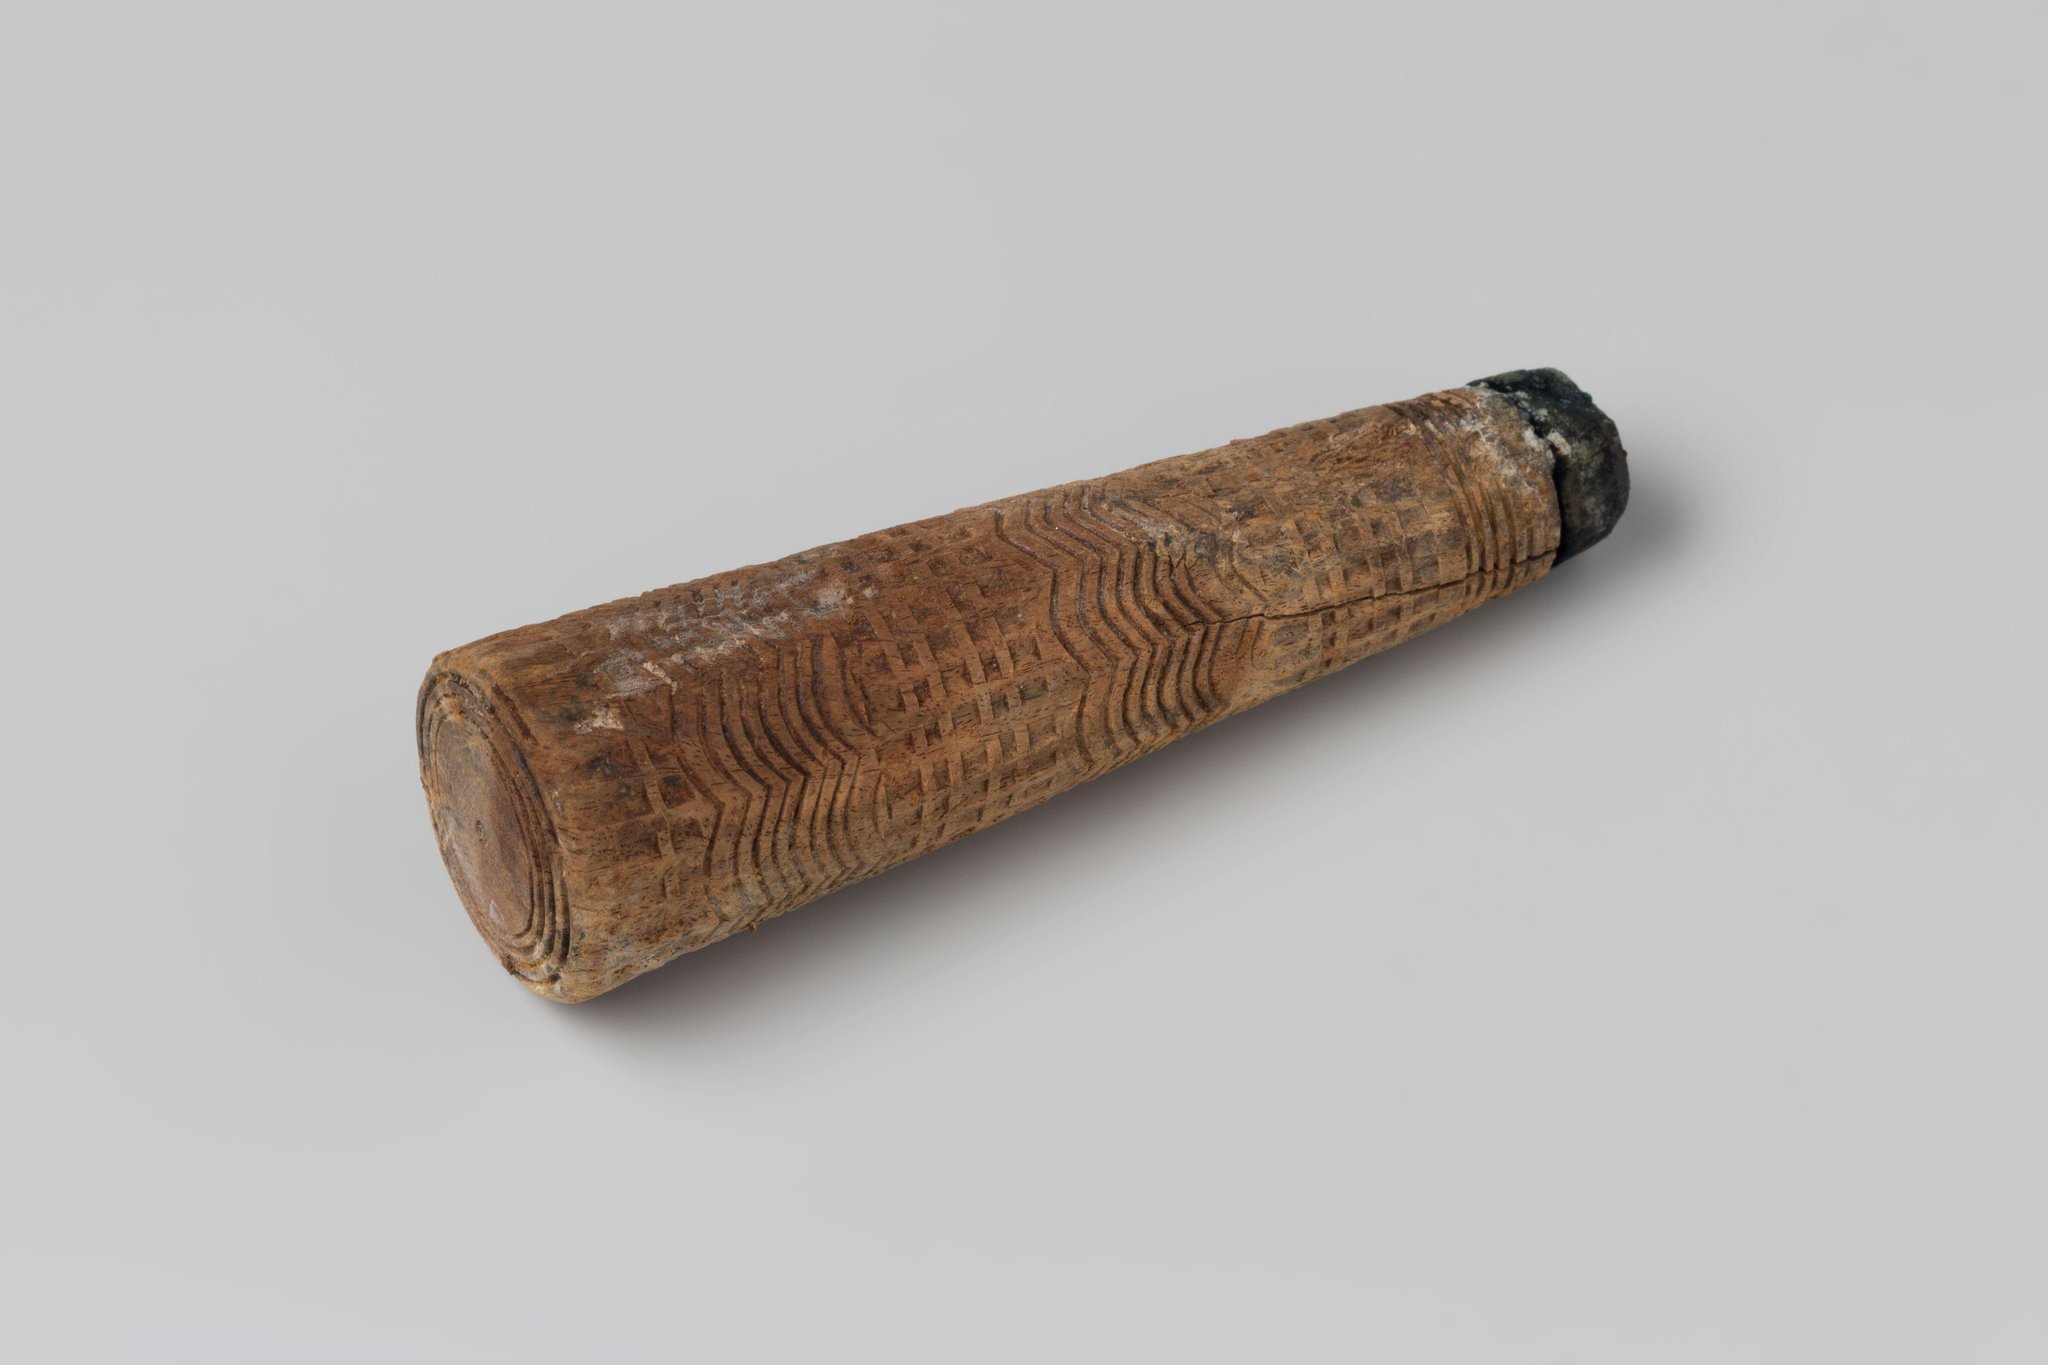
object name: knife handle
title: Messenheft uit het wrak van de Oost-Indiëvaarder Hollandia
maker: Anonymous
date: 1700-1743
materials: copper, wood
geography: netherlands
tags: verenigde oostindische compagnie, hollandia (schip), annet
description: Knife, handle, cylindrical: tapering; id. NG 1979-403H, ferrule, id. NG 1980-27H426.